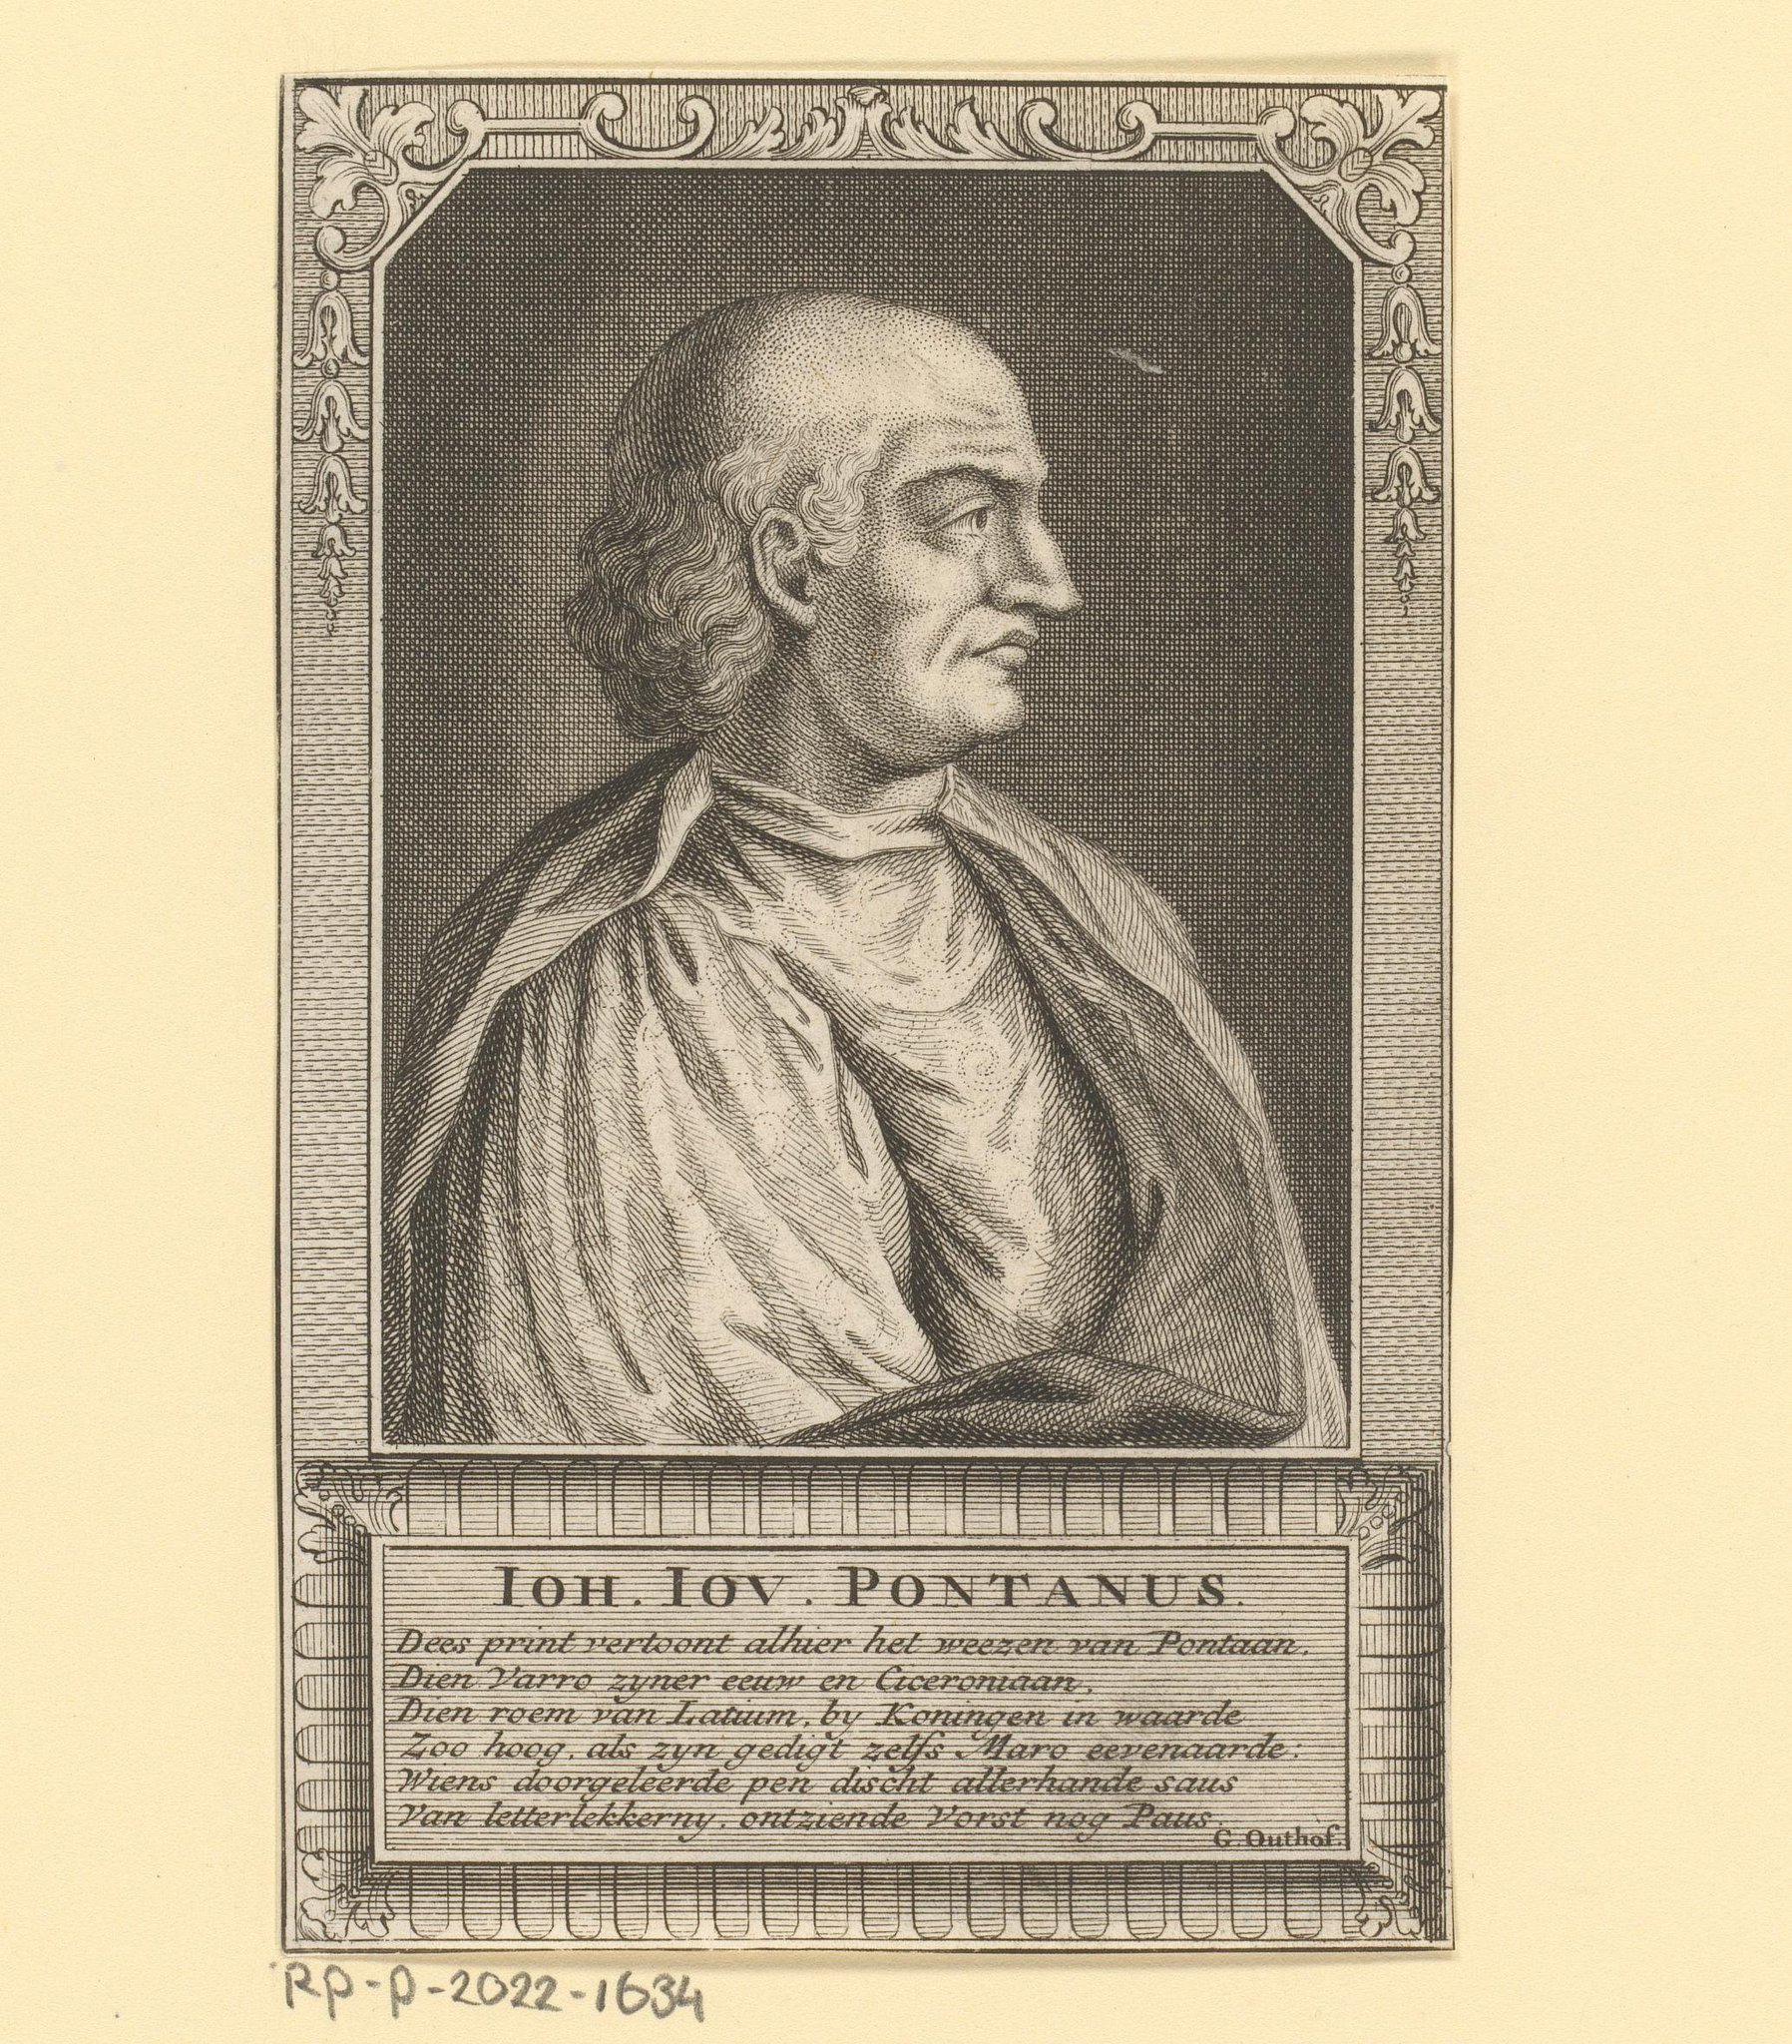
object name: print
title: Portret van Giovanni Gioviano Pontano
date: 1700-1742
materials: paper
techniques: engraving, etching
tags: naples, historical persons, portrait of a writer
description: Met zesregelig onderschrift in het Nederlands.